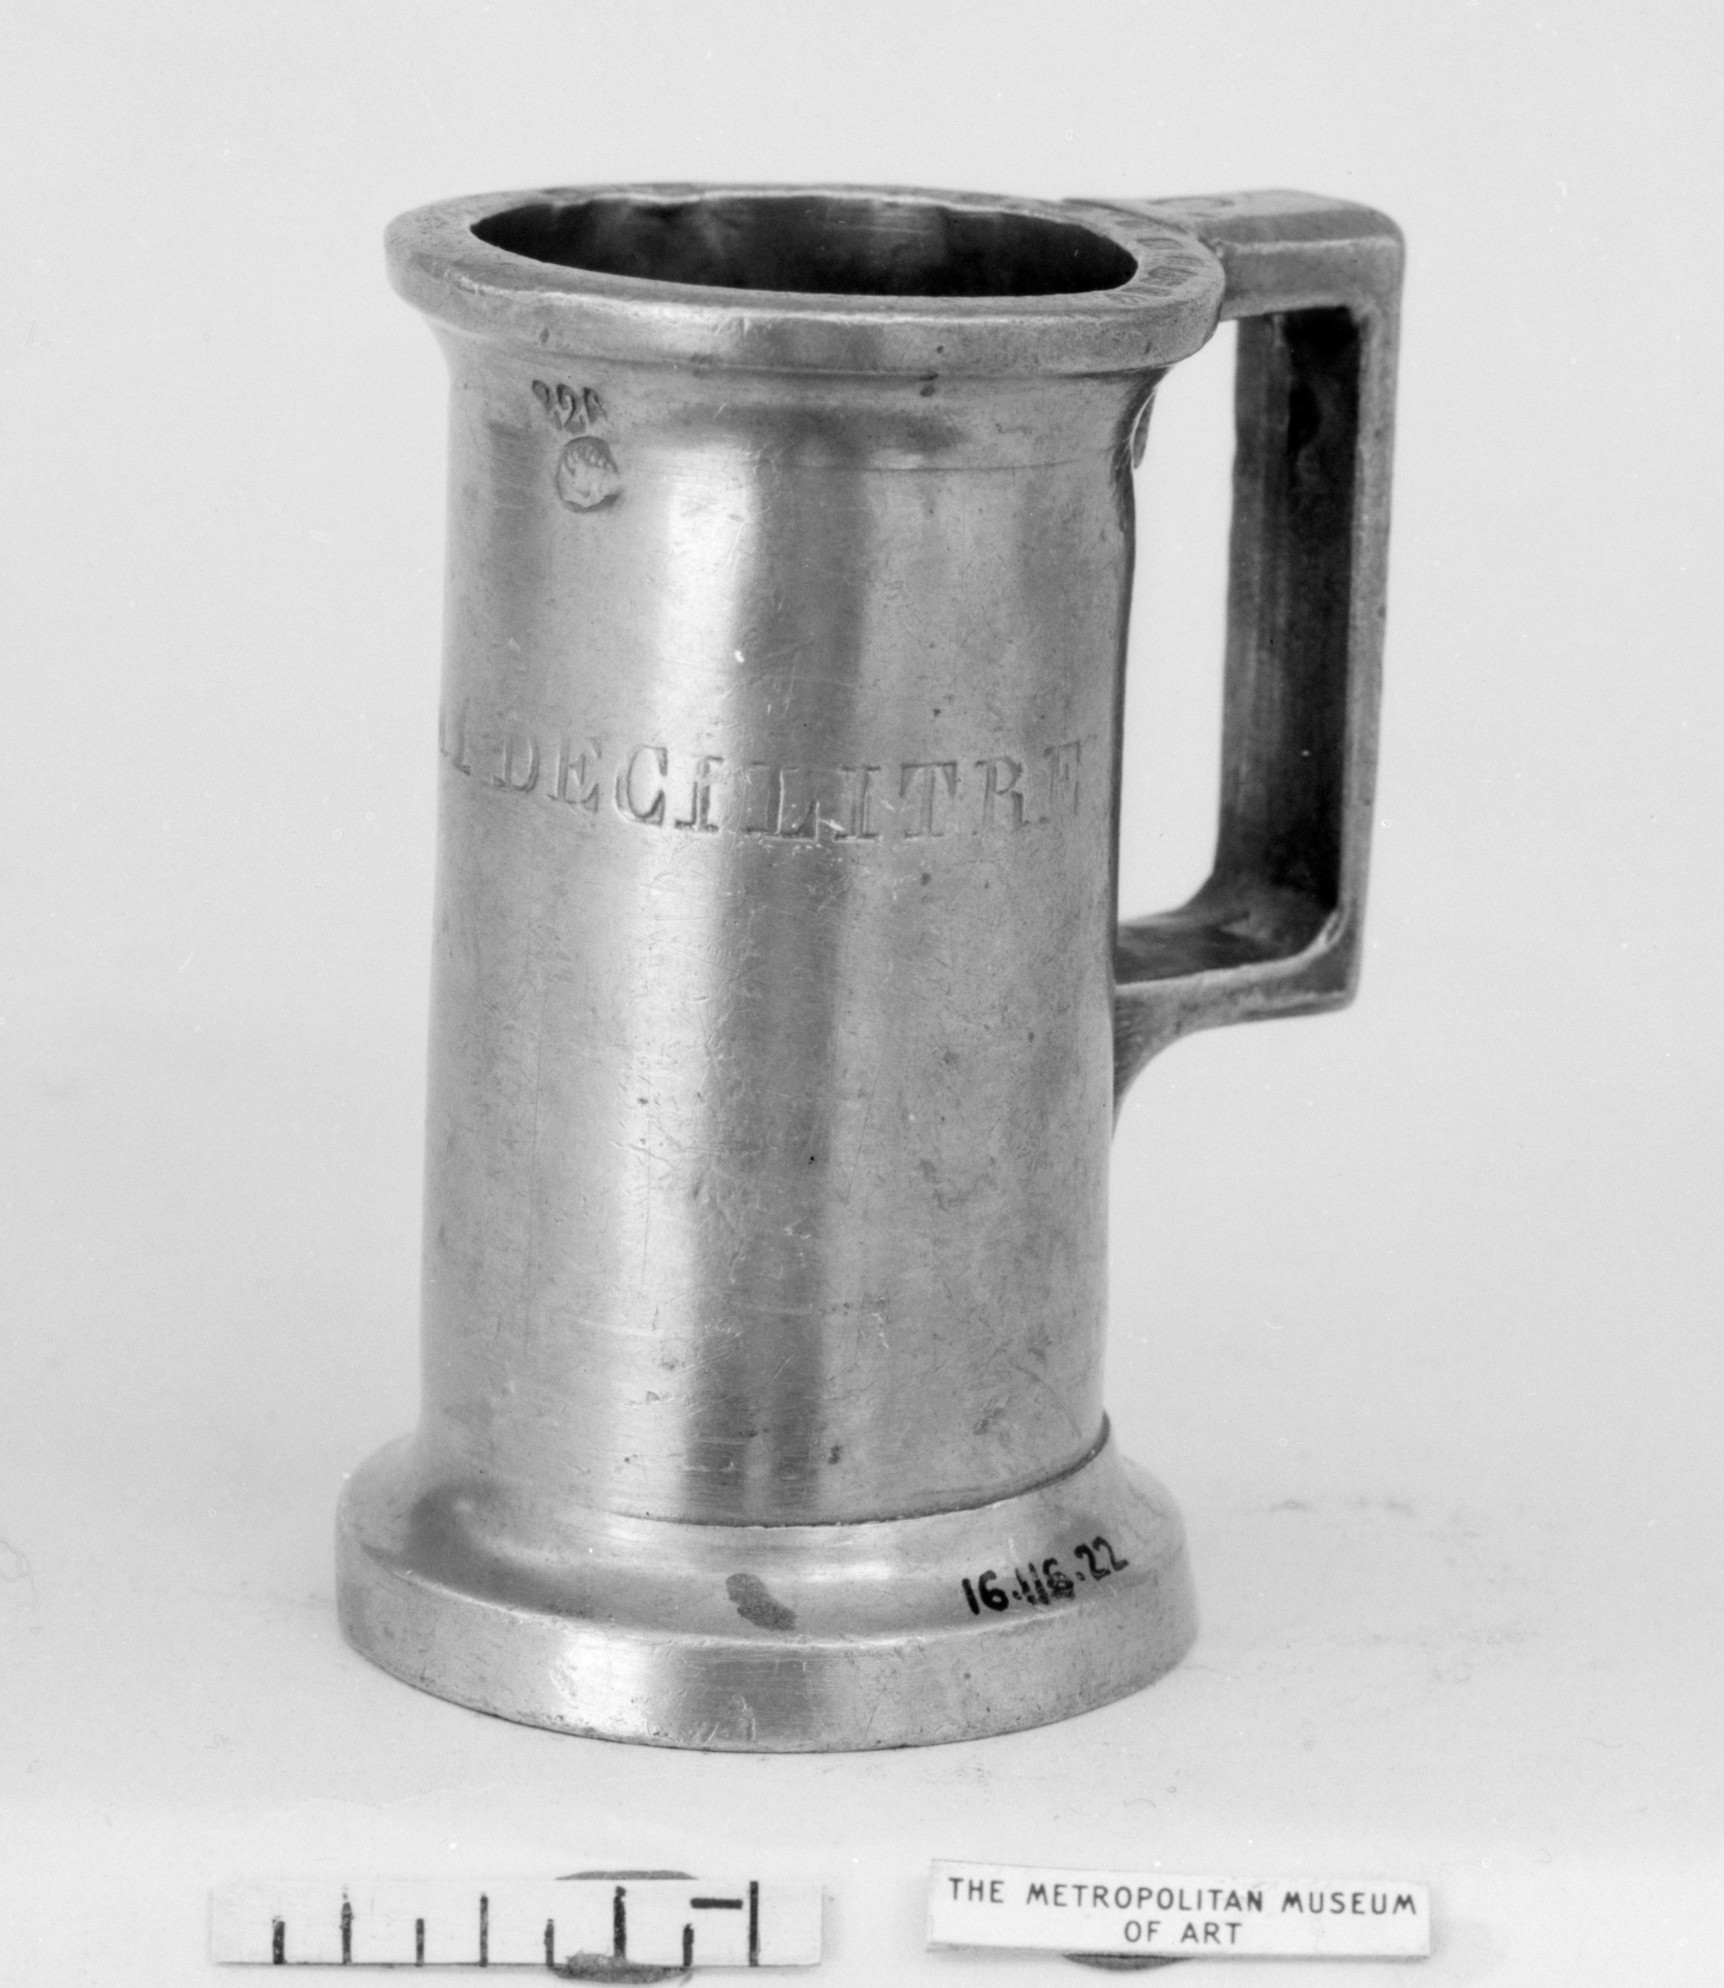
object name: measure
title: Measure (one of a set of seven)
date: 1801-1900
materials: pewter